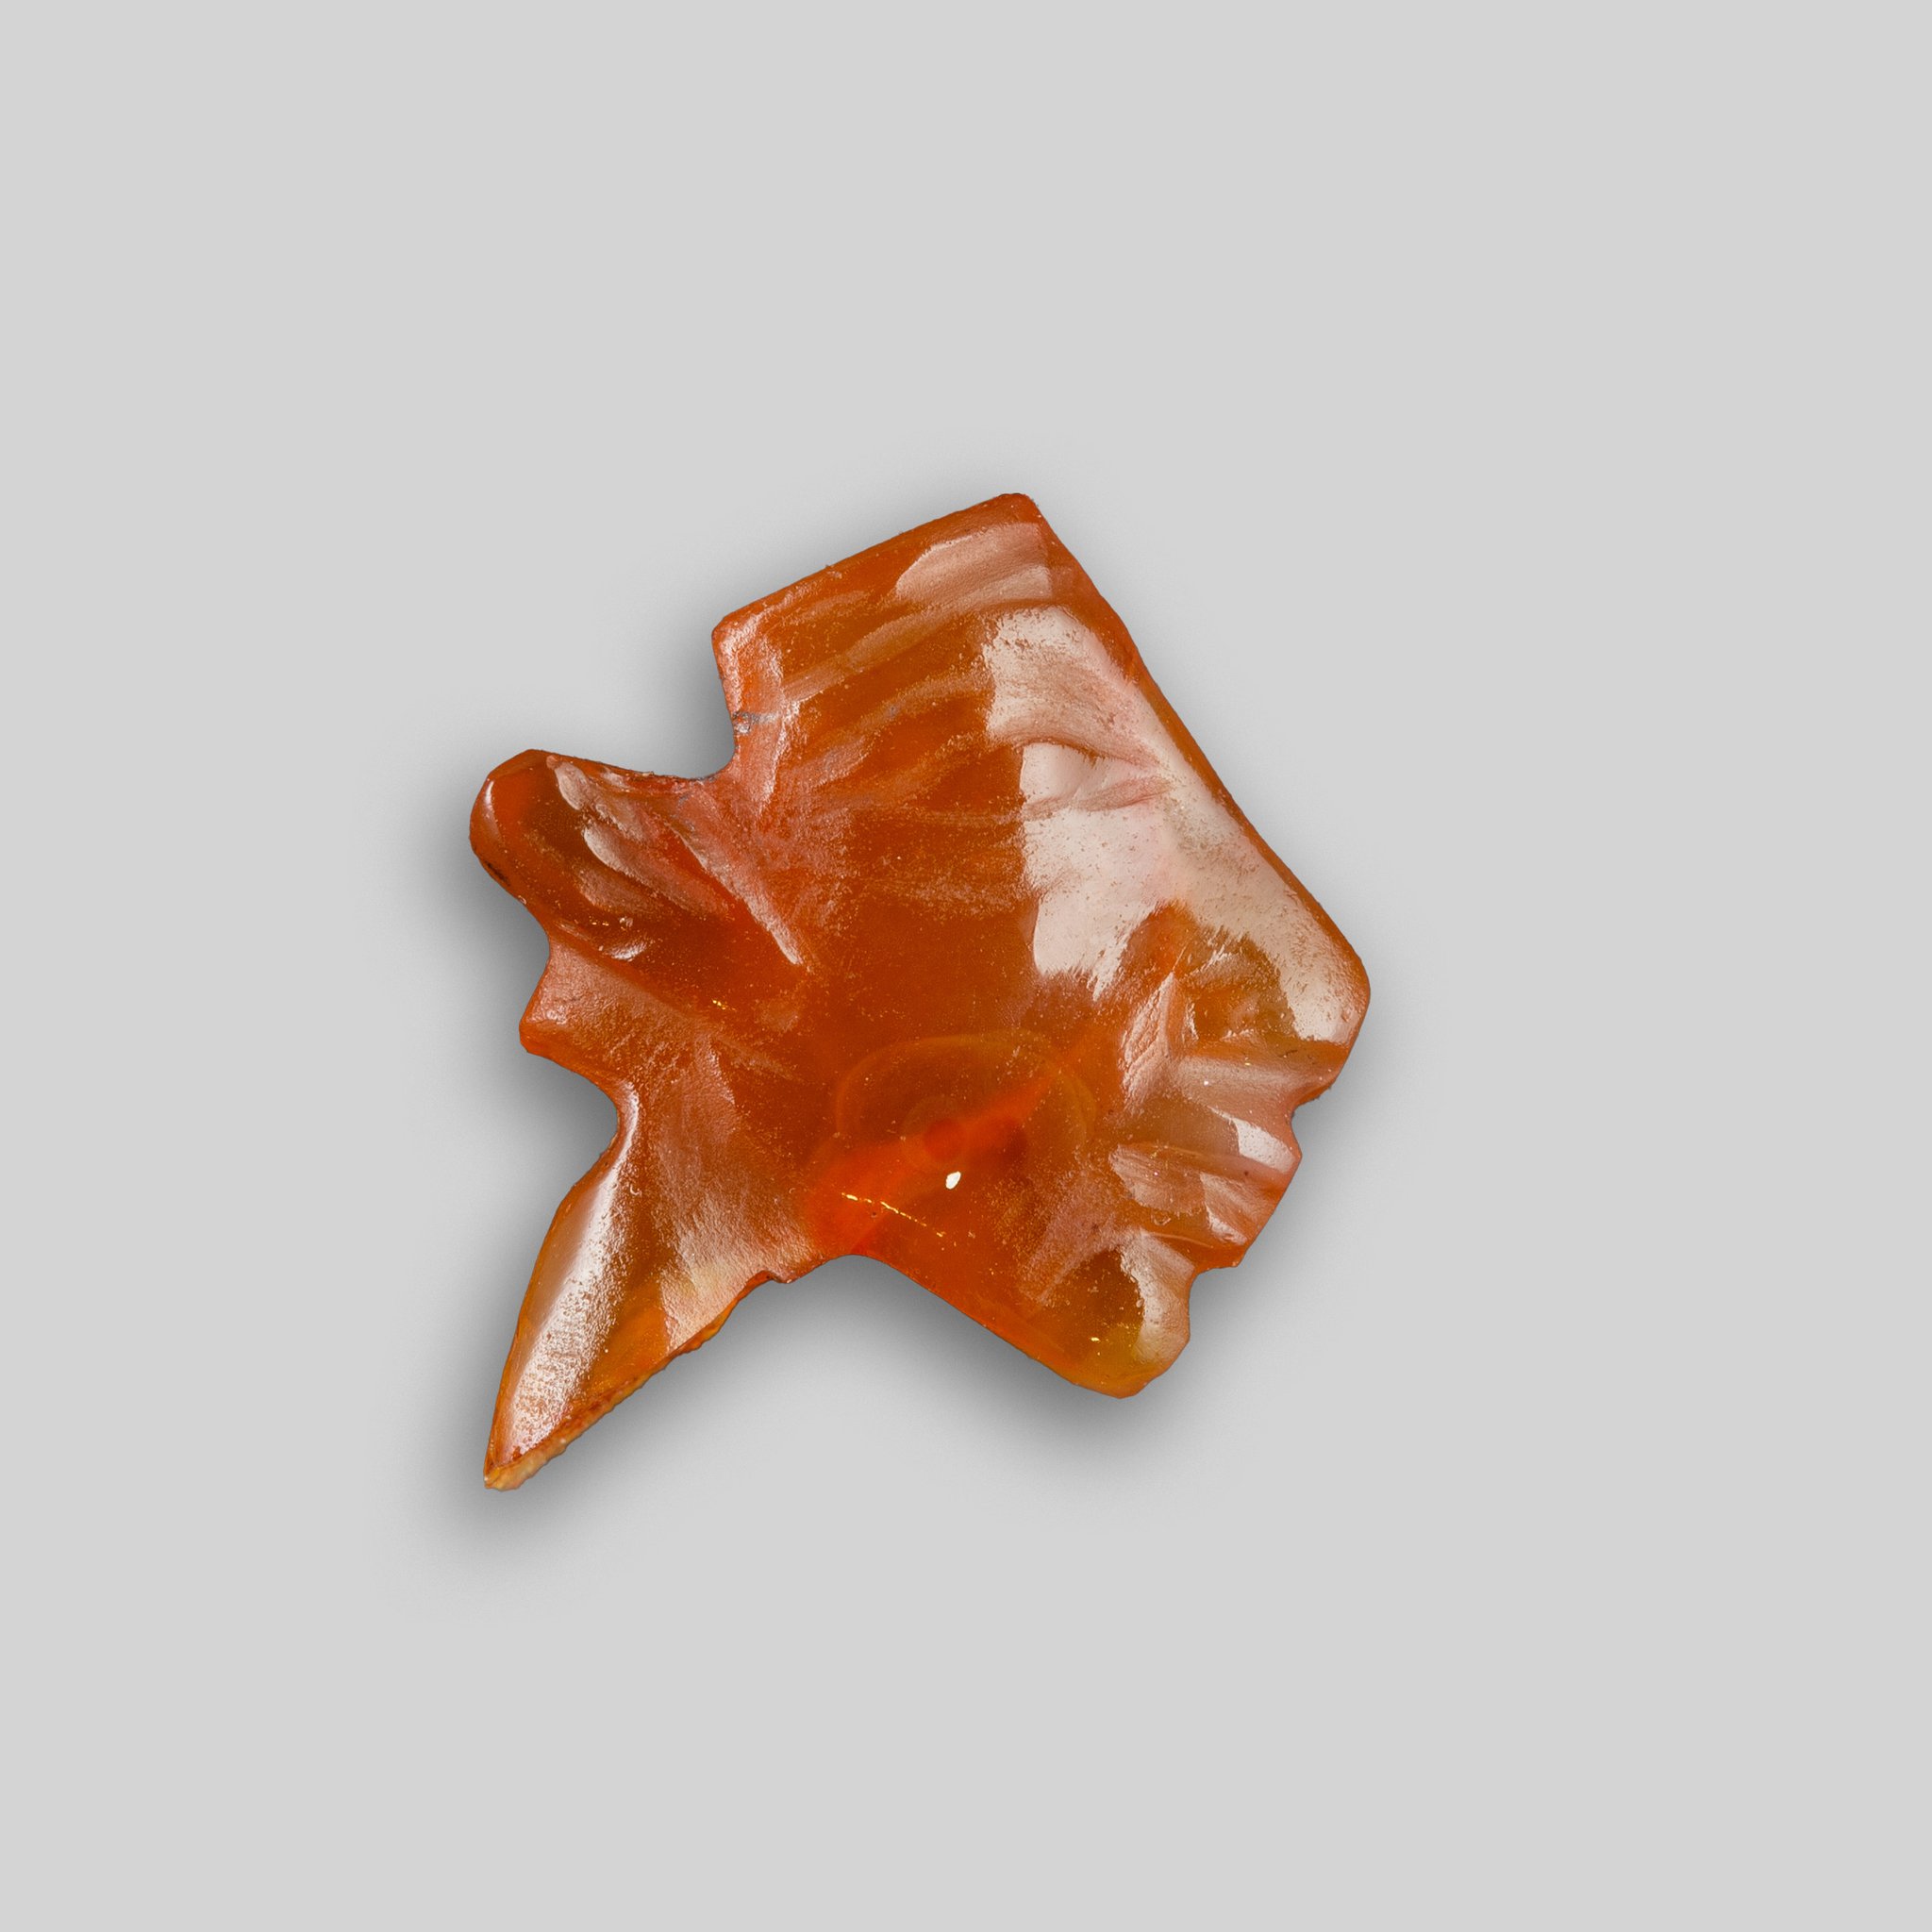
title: Profile Face Inlay of King Akhenaten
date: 1353-1336 BCE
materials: gemstone